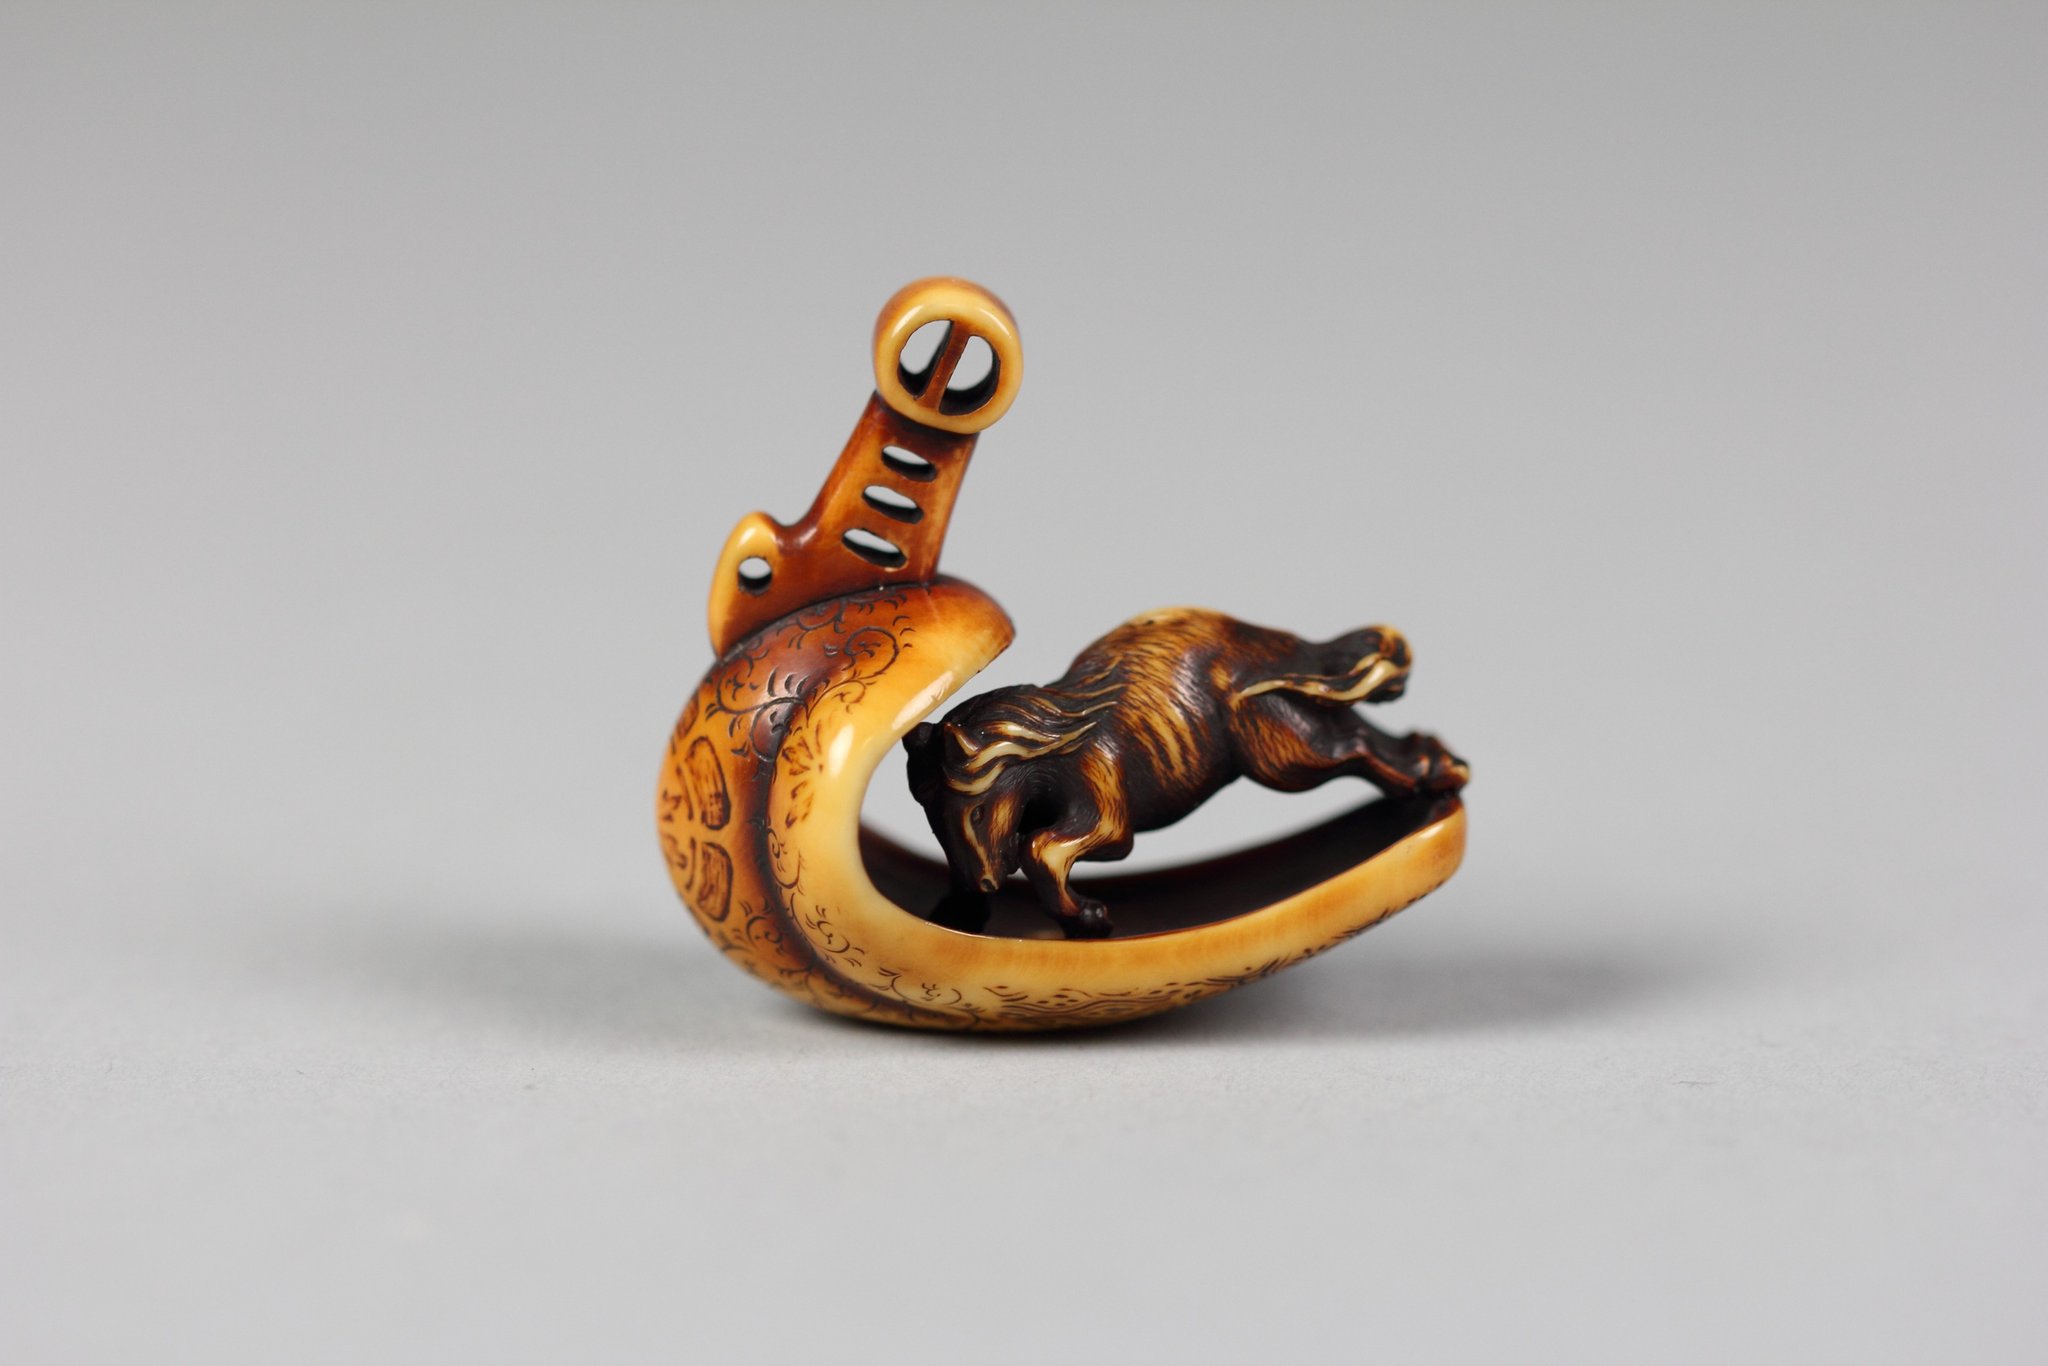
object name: netsuke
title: Netsuke of Horse in a Boat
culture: japanese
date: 1801-1900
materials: ivory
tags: boats